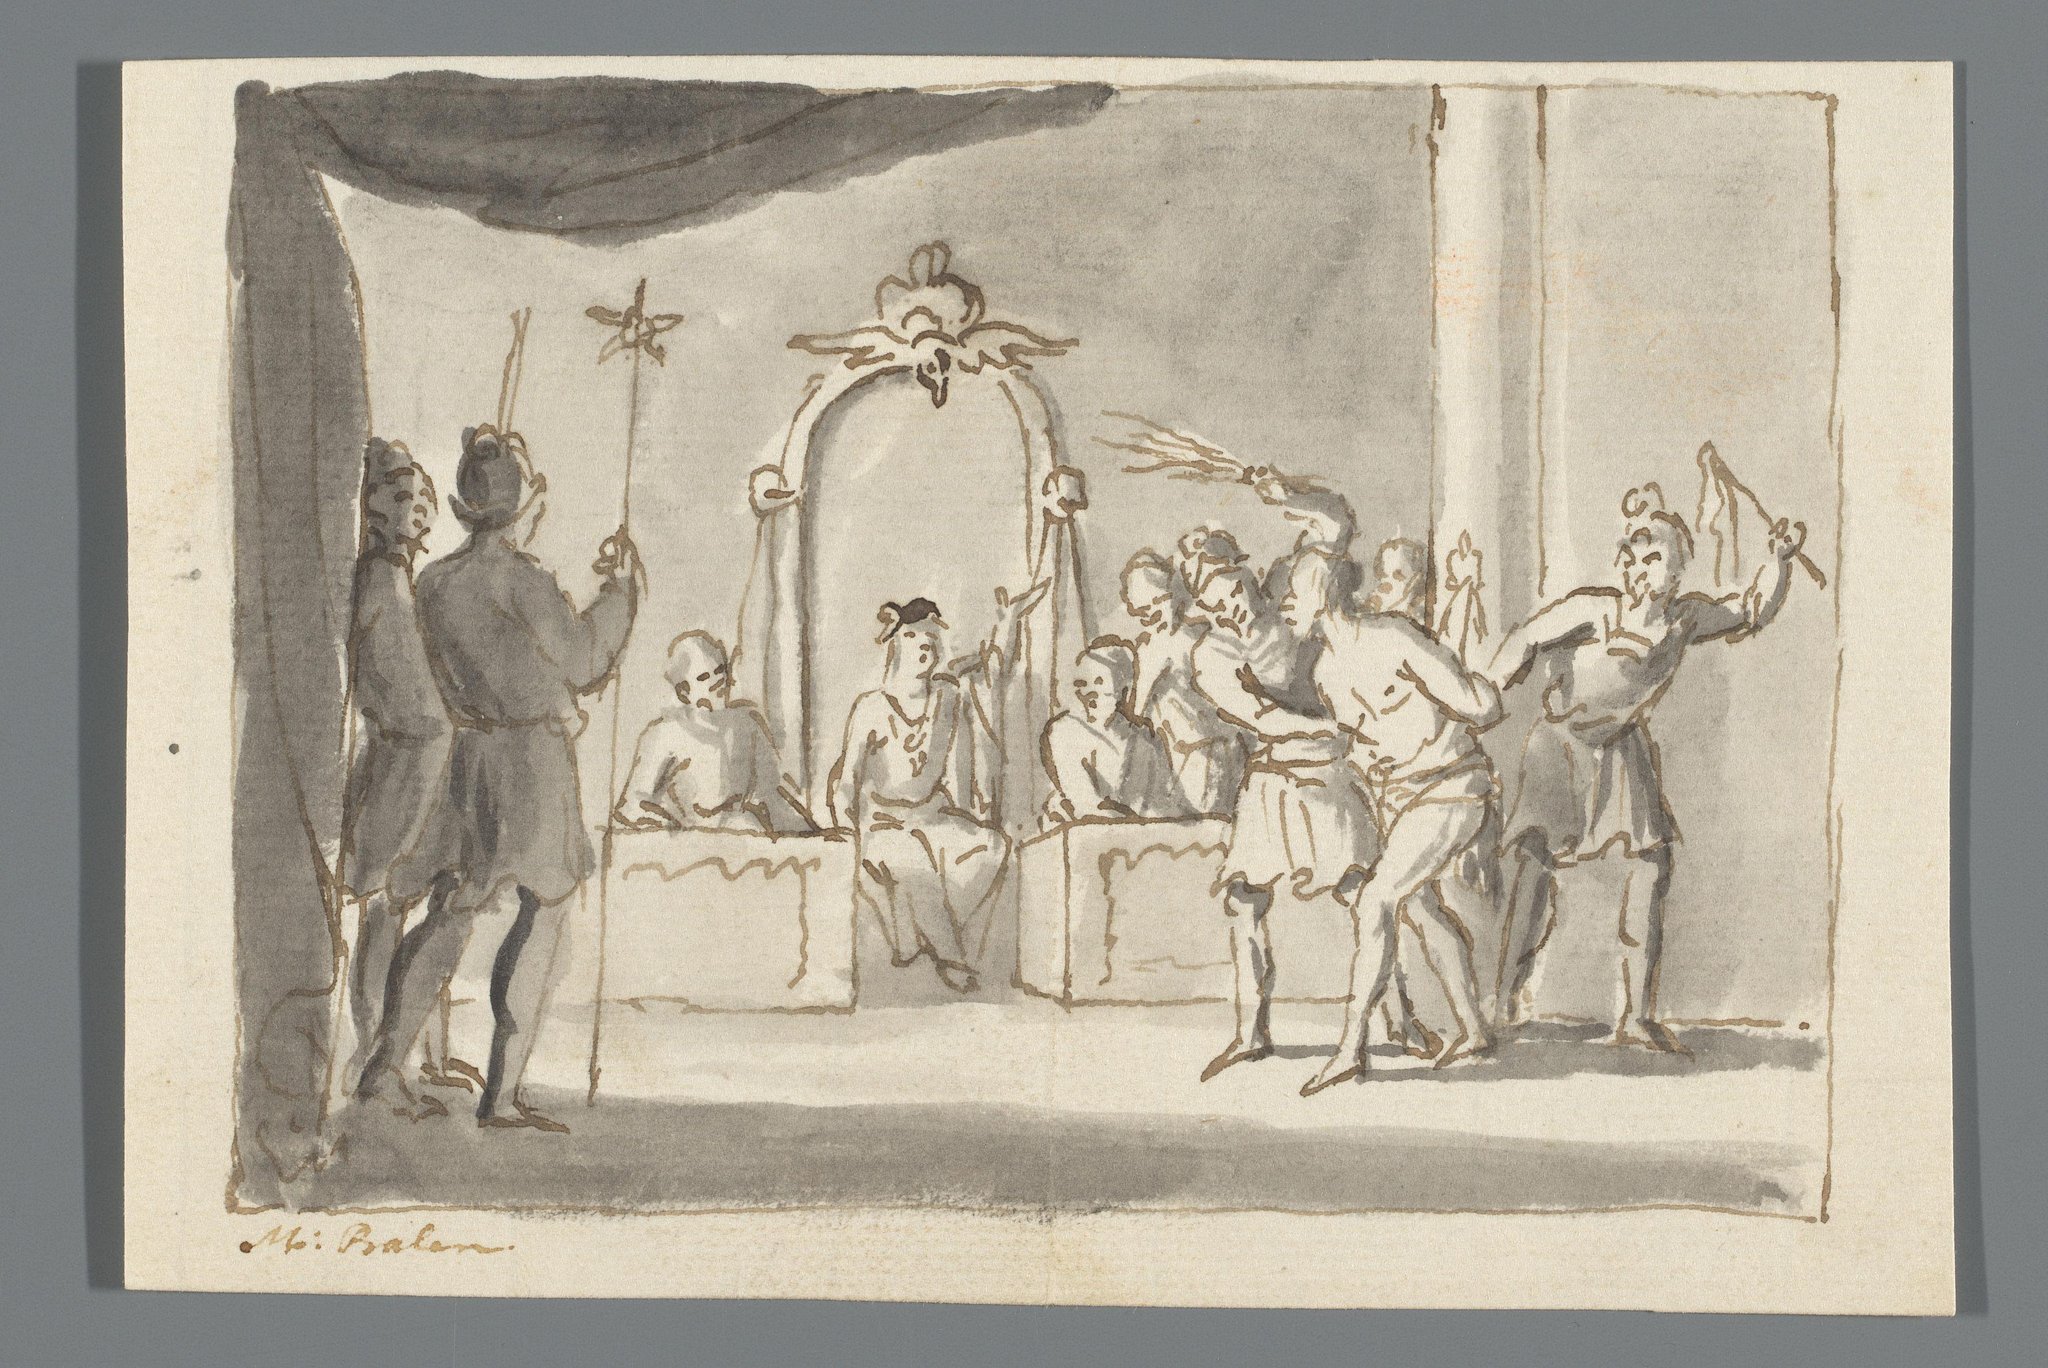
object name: drawing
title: Geseling van Christus voor Pontius Pilatus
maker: matthijs balen (1684-1766)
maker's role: draughtsman, painter, print maker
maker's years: 1684-1766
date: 1694-1766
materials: paper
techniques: brush, pen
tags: christ before pontius pilate (matthew 27:11-26; mark 15:2-15; luke 23:2-7, 23:13-25; john 18:28 - 19:16), flagellation by soldiers, christ usually tied to a column (matthew 27:26; mark 15:15; john 19:1)